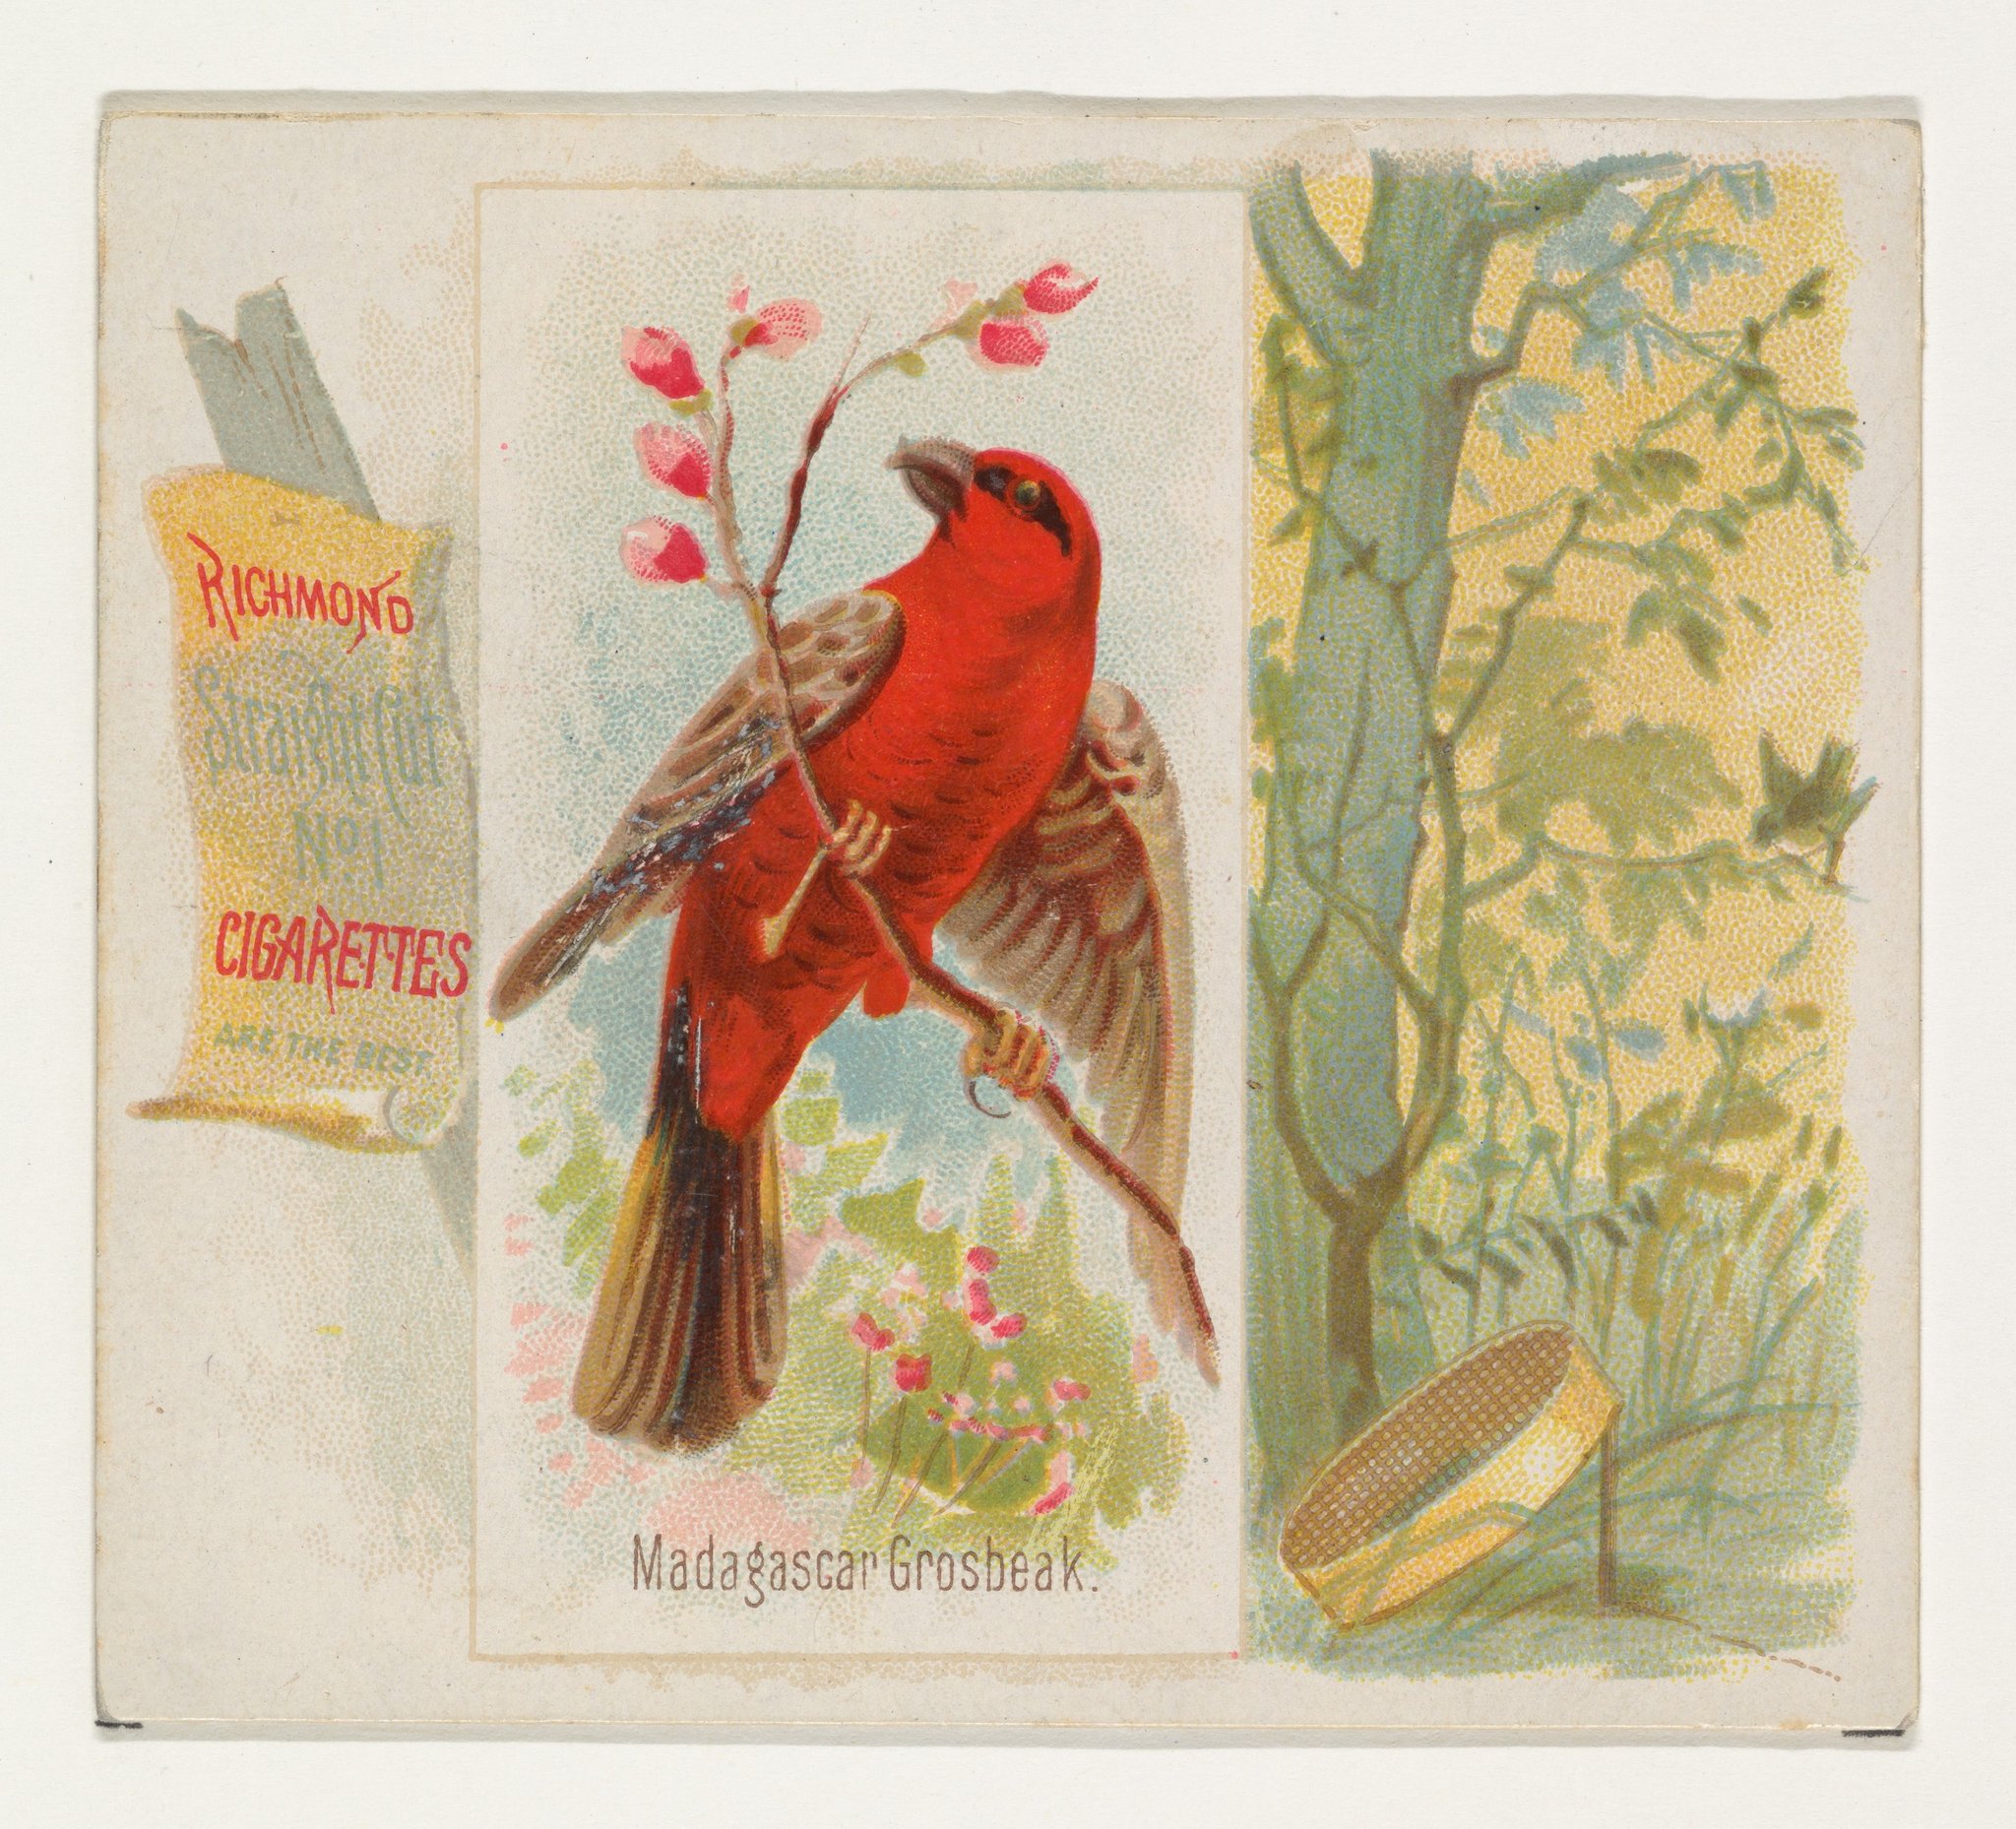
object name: print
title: Madagascar Grosbeak, from the Song Birds of the World series (N42) for Allen & Ginter Cigarettes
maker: allen & ginter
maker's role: publisher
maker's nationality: american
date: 1890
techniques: color lithograph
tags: birds